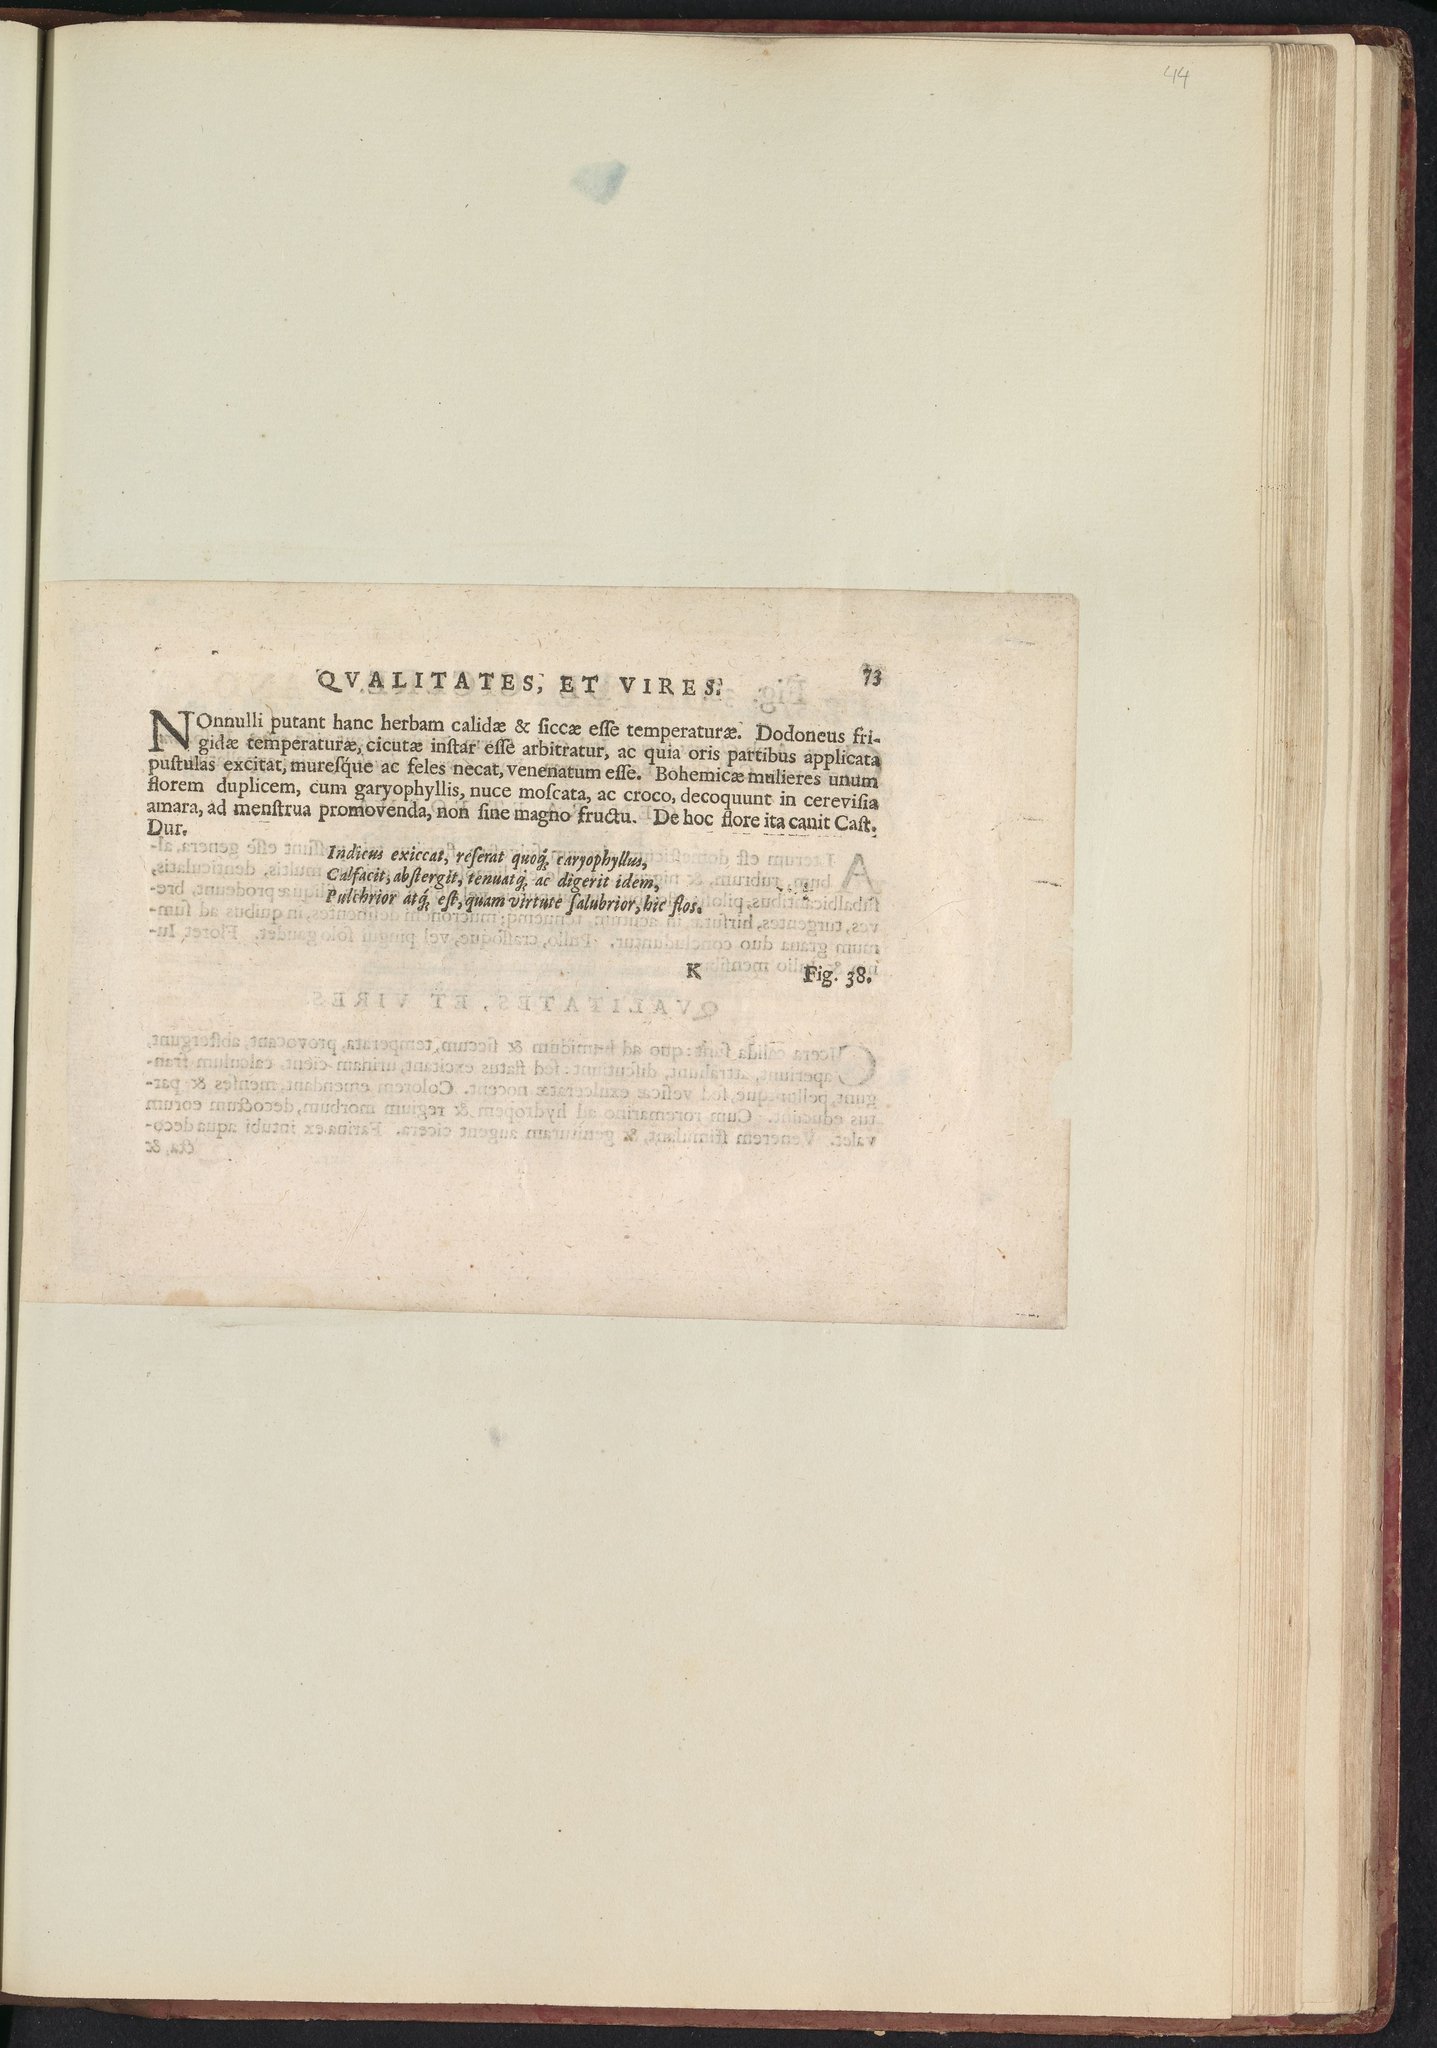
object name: text sheet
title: Fig. 37 'De Flore Aphricano' in De Boodts herbarium van 1640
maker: anselmus boëtius de boodt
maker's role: draughtsman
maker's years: 1550-1632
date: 1640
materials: ink, paper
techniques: letterpress printing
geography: bruges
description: Beschrijving bij Fig. 37 op p. 73 in: Anselmi Boëtii de Boot I.C. Brugensis & Rodolphi II. Imp. Roman. medici a cubiculis Florum, Herbarum, ac fructuum selectiorum icones, & vires pleraeque hactenus ignotæ. Onderdeel van het album met bladen en platen uit De Boodts herbarium van 1640. Het twaalfde van twaalf albums met aquarellen van dieren, vogels en planten bekend rond 1600, gemaakt in opdracht van keizer Rudolf II.